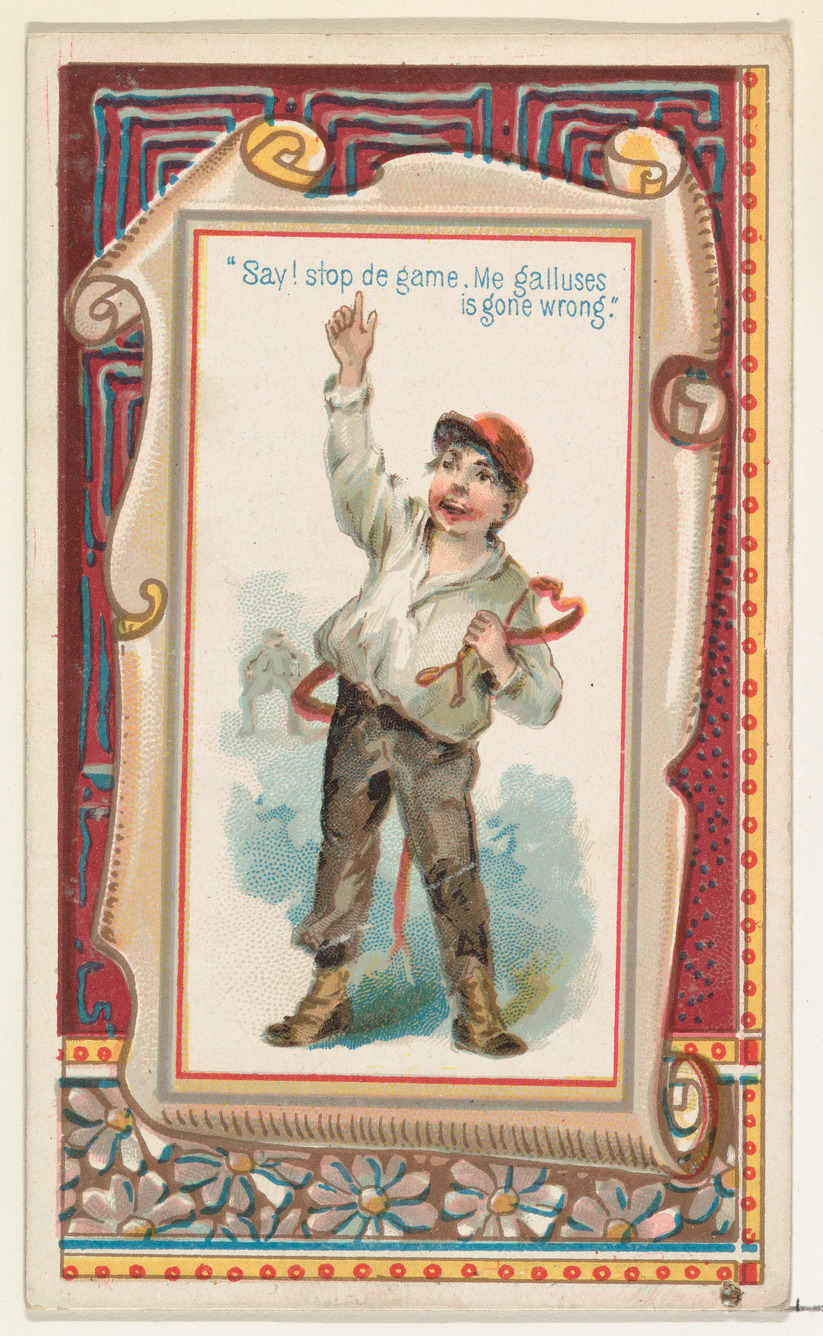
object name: print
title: "Say! stop the game. Me galluses is gone wrong," from the Terrors of America set (N136) issued by Duke Sons & Co. to promote Honest Long Cut Tobacco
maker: w. duke, sons & co.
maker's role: publisher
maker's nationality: american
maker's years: 1870-1920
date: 1888-1889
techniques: color lithograph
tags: boys